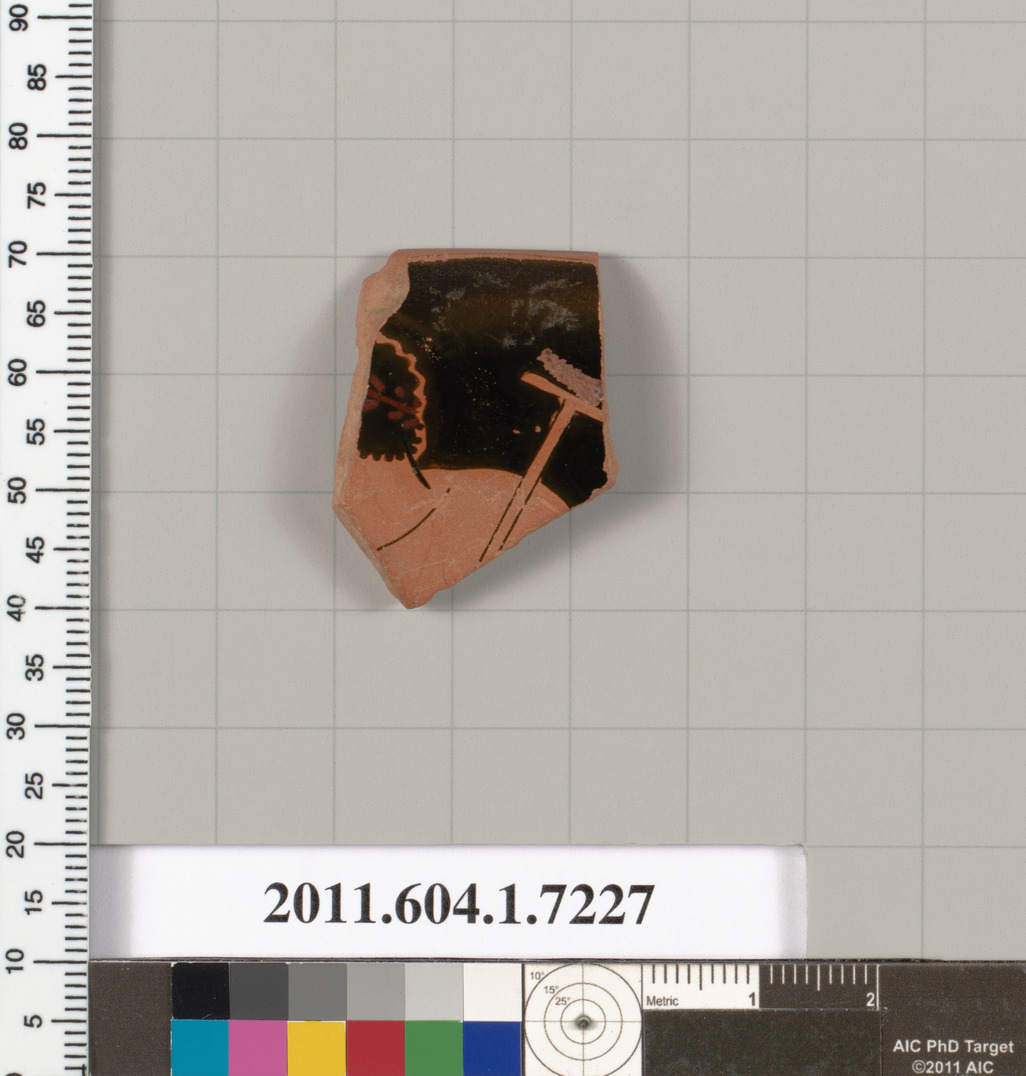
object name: kylix fragment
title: Terracotta rim fragment of a kylix (drinking cup)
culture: greek, attic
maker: makron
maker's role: artist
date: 500-480 BCE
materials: terracotta